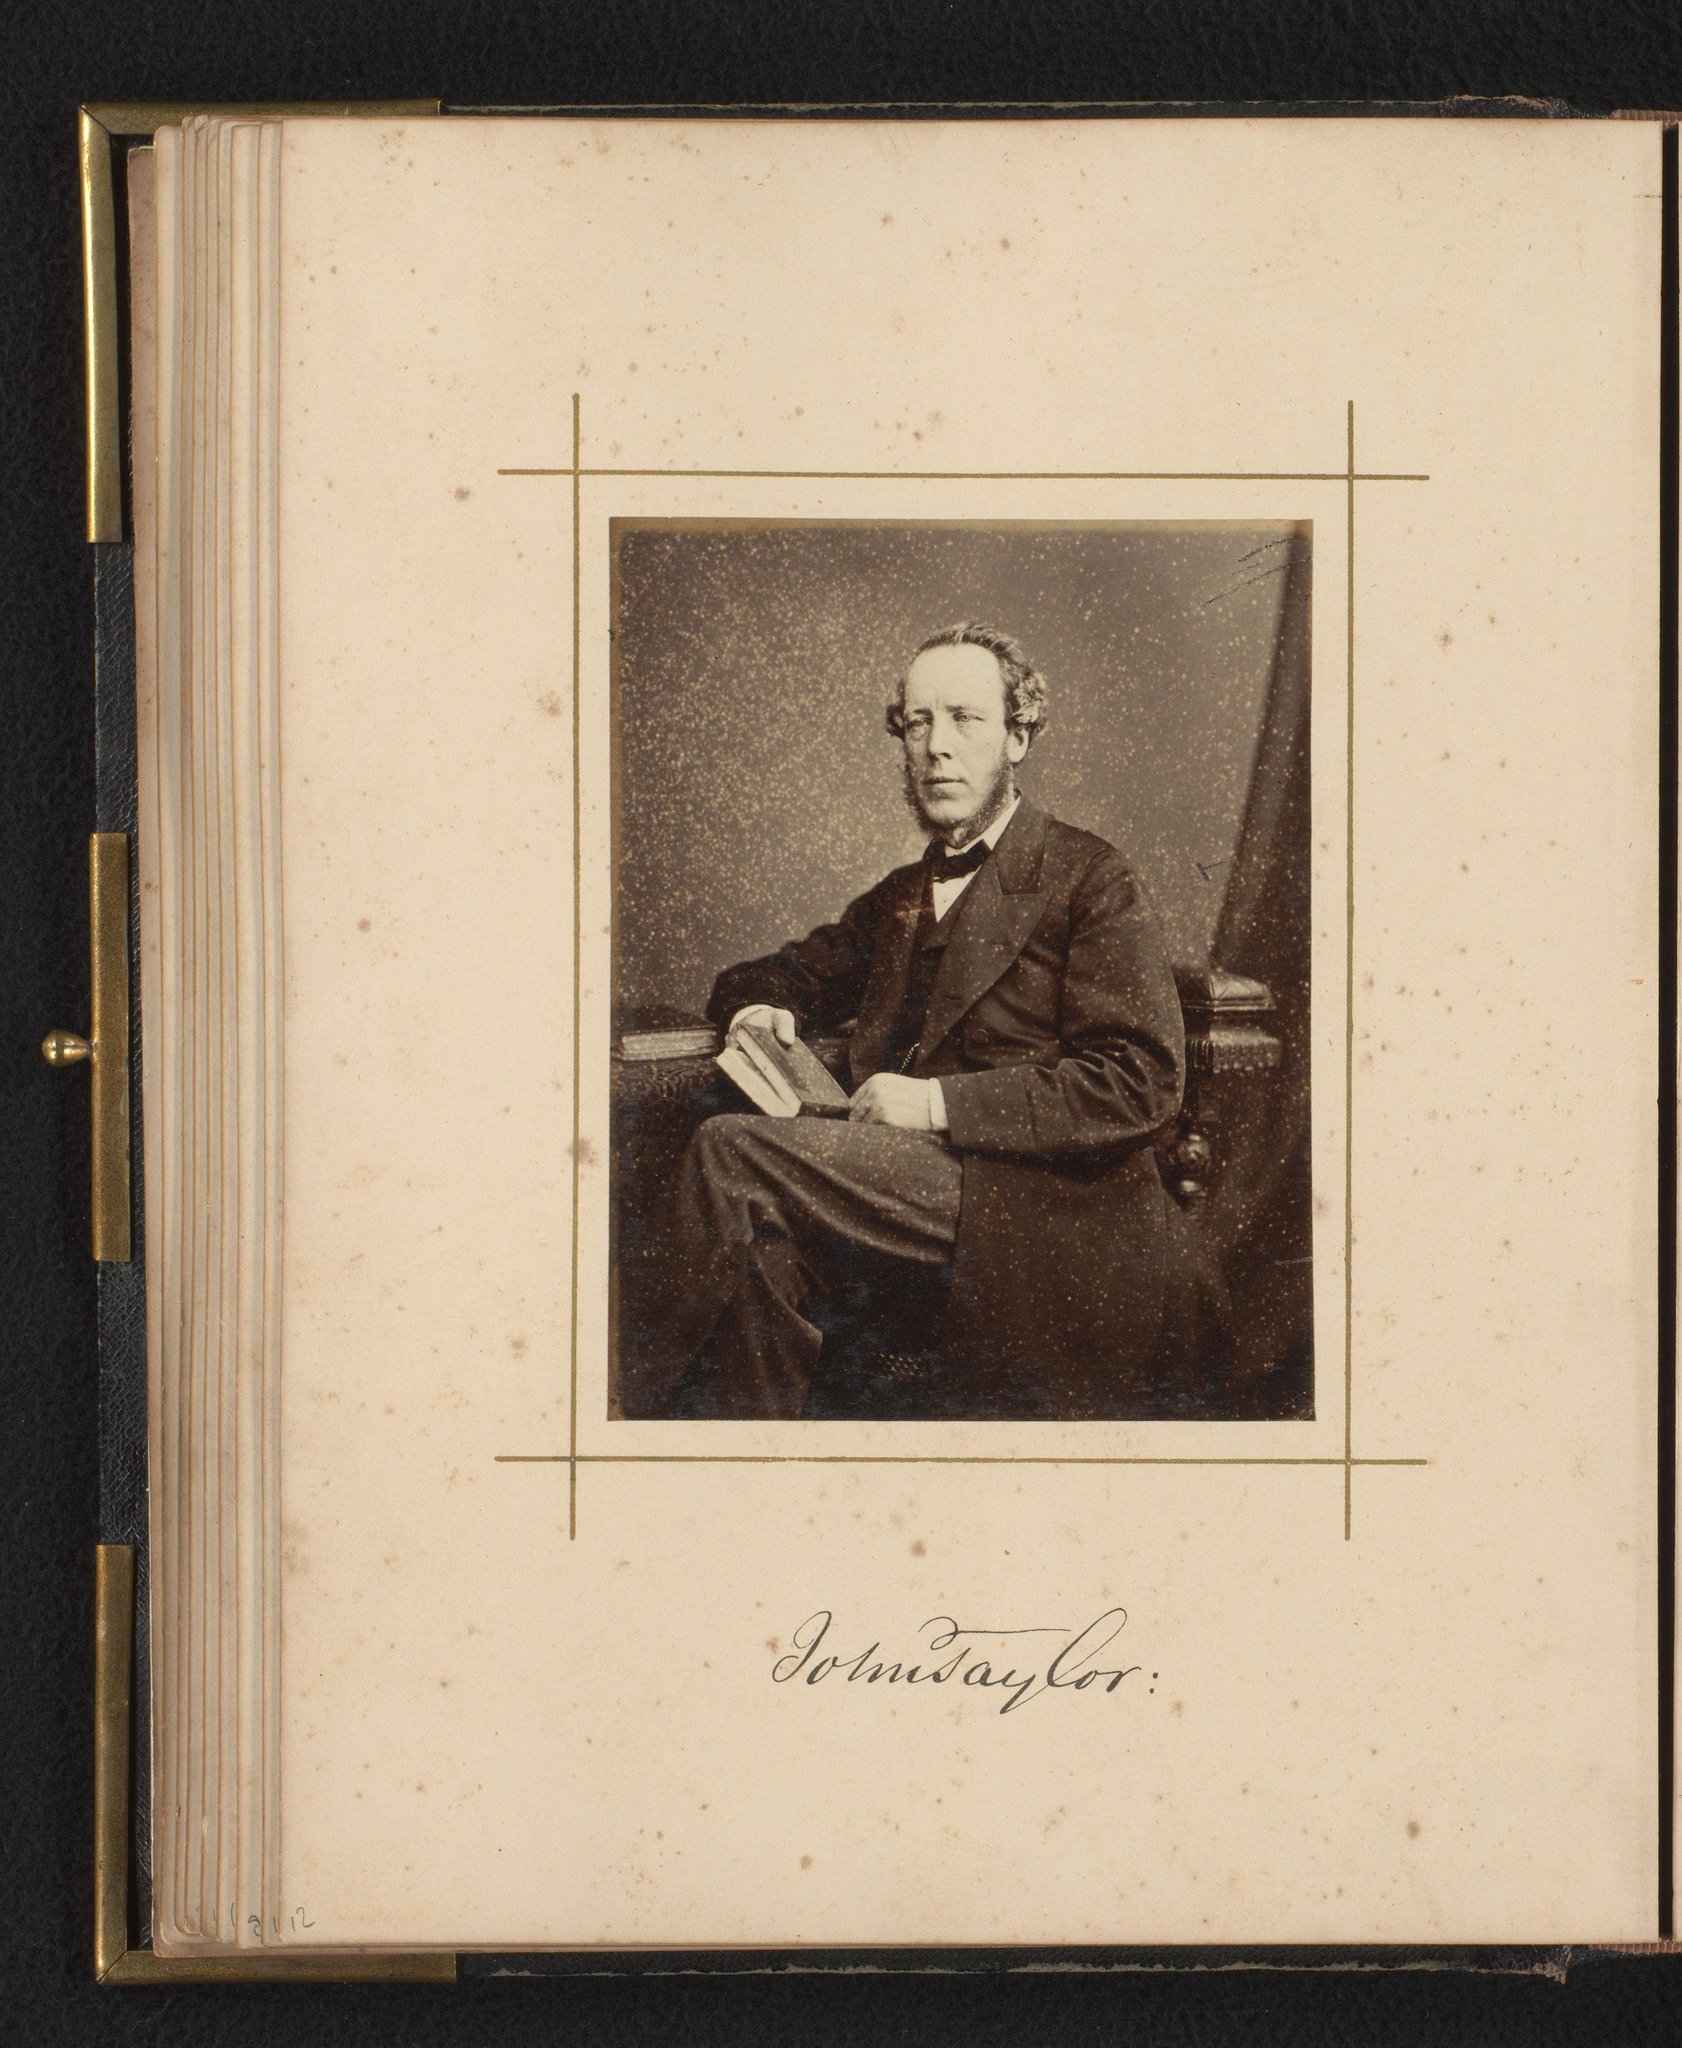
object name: photograph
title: Portret van John Taylor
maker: Anonymous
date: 1866-1871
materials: photographic support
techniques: albumen print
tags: john taylor, historical persons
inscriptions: name: ‘John Taylor’